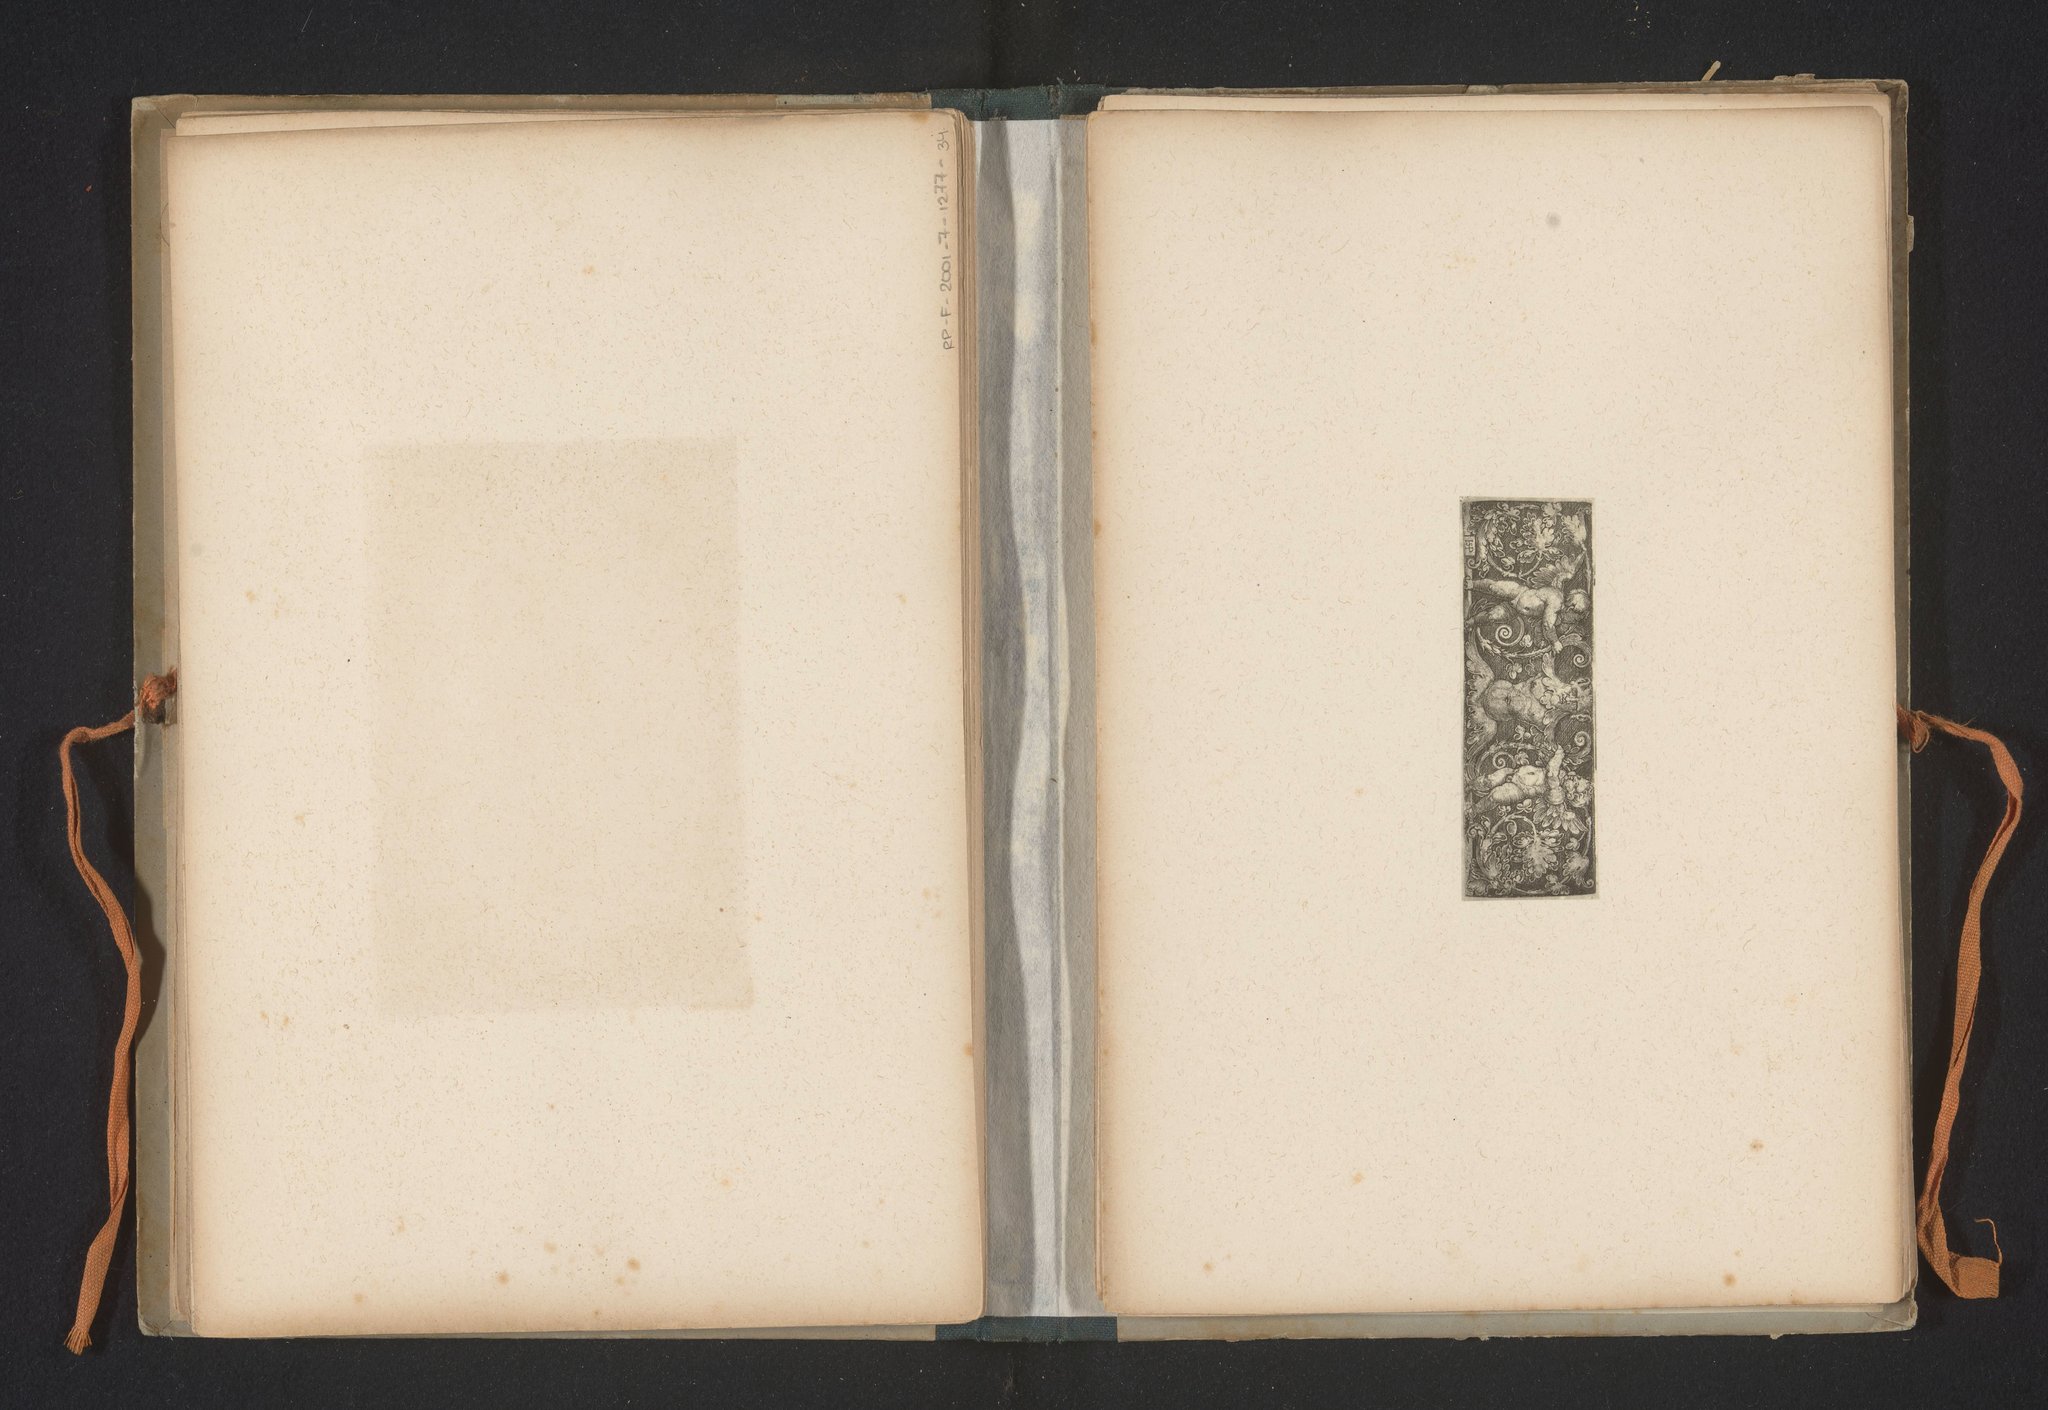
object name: reproduction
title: Reproductie van een prent van groteske ornamenten met twee cupido's door Hans Sebald Beham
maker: hans sebald beham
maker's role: designer, draughtsman, print maker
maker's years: 1500-1550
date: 1866-1871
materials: paper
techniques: woodburytype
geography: brussels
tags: ornament ~ grotesque, cupids: 'amores', 'amoretti', 'putti'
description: Deze prent maakt deel uit van een omslag met 57 prenten op 54 bladen.